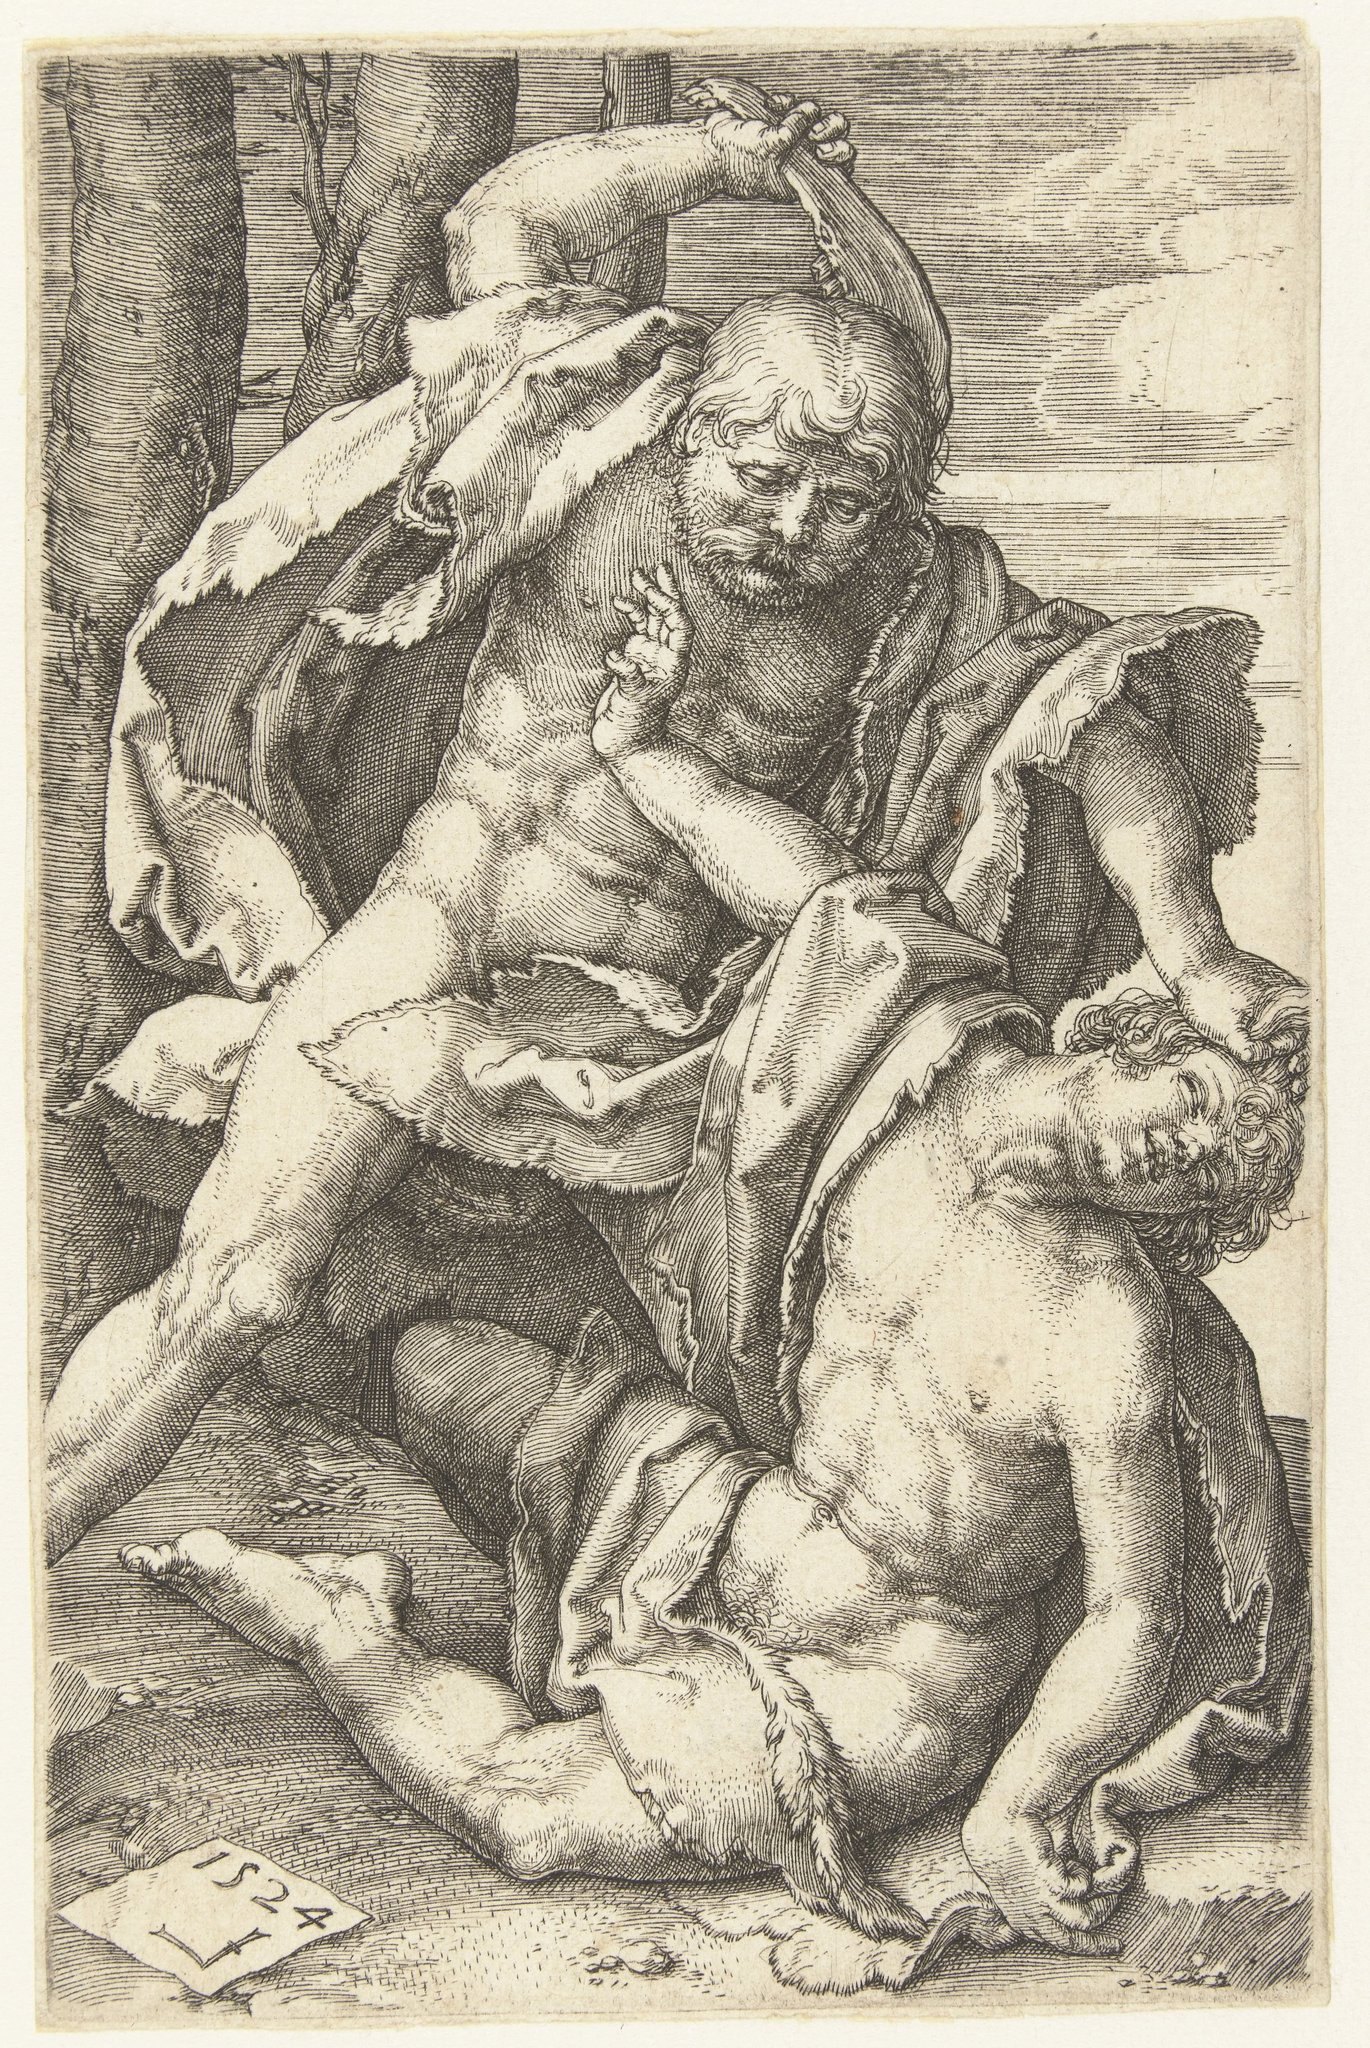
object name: print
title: Kaïn doodt Abel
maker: lucas van leyden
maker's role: draughtsman, painter, print maker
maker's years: 1494-1533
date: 1524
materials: paper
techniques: engraving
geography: low countries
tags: the killing of abel: cain slays him with a stone, a club or a jaw-bone, alternatively with a spade or another tool as weapon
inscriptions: date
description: Kaïn met opgeheven stuk bot, trekt hoofd van zittende Abel aan haren naar achter.